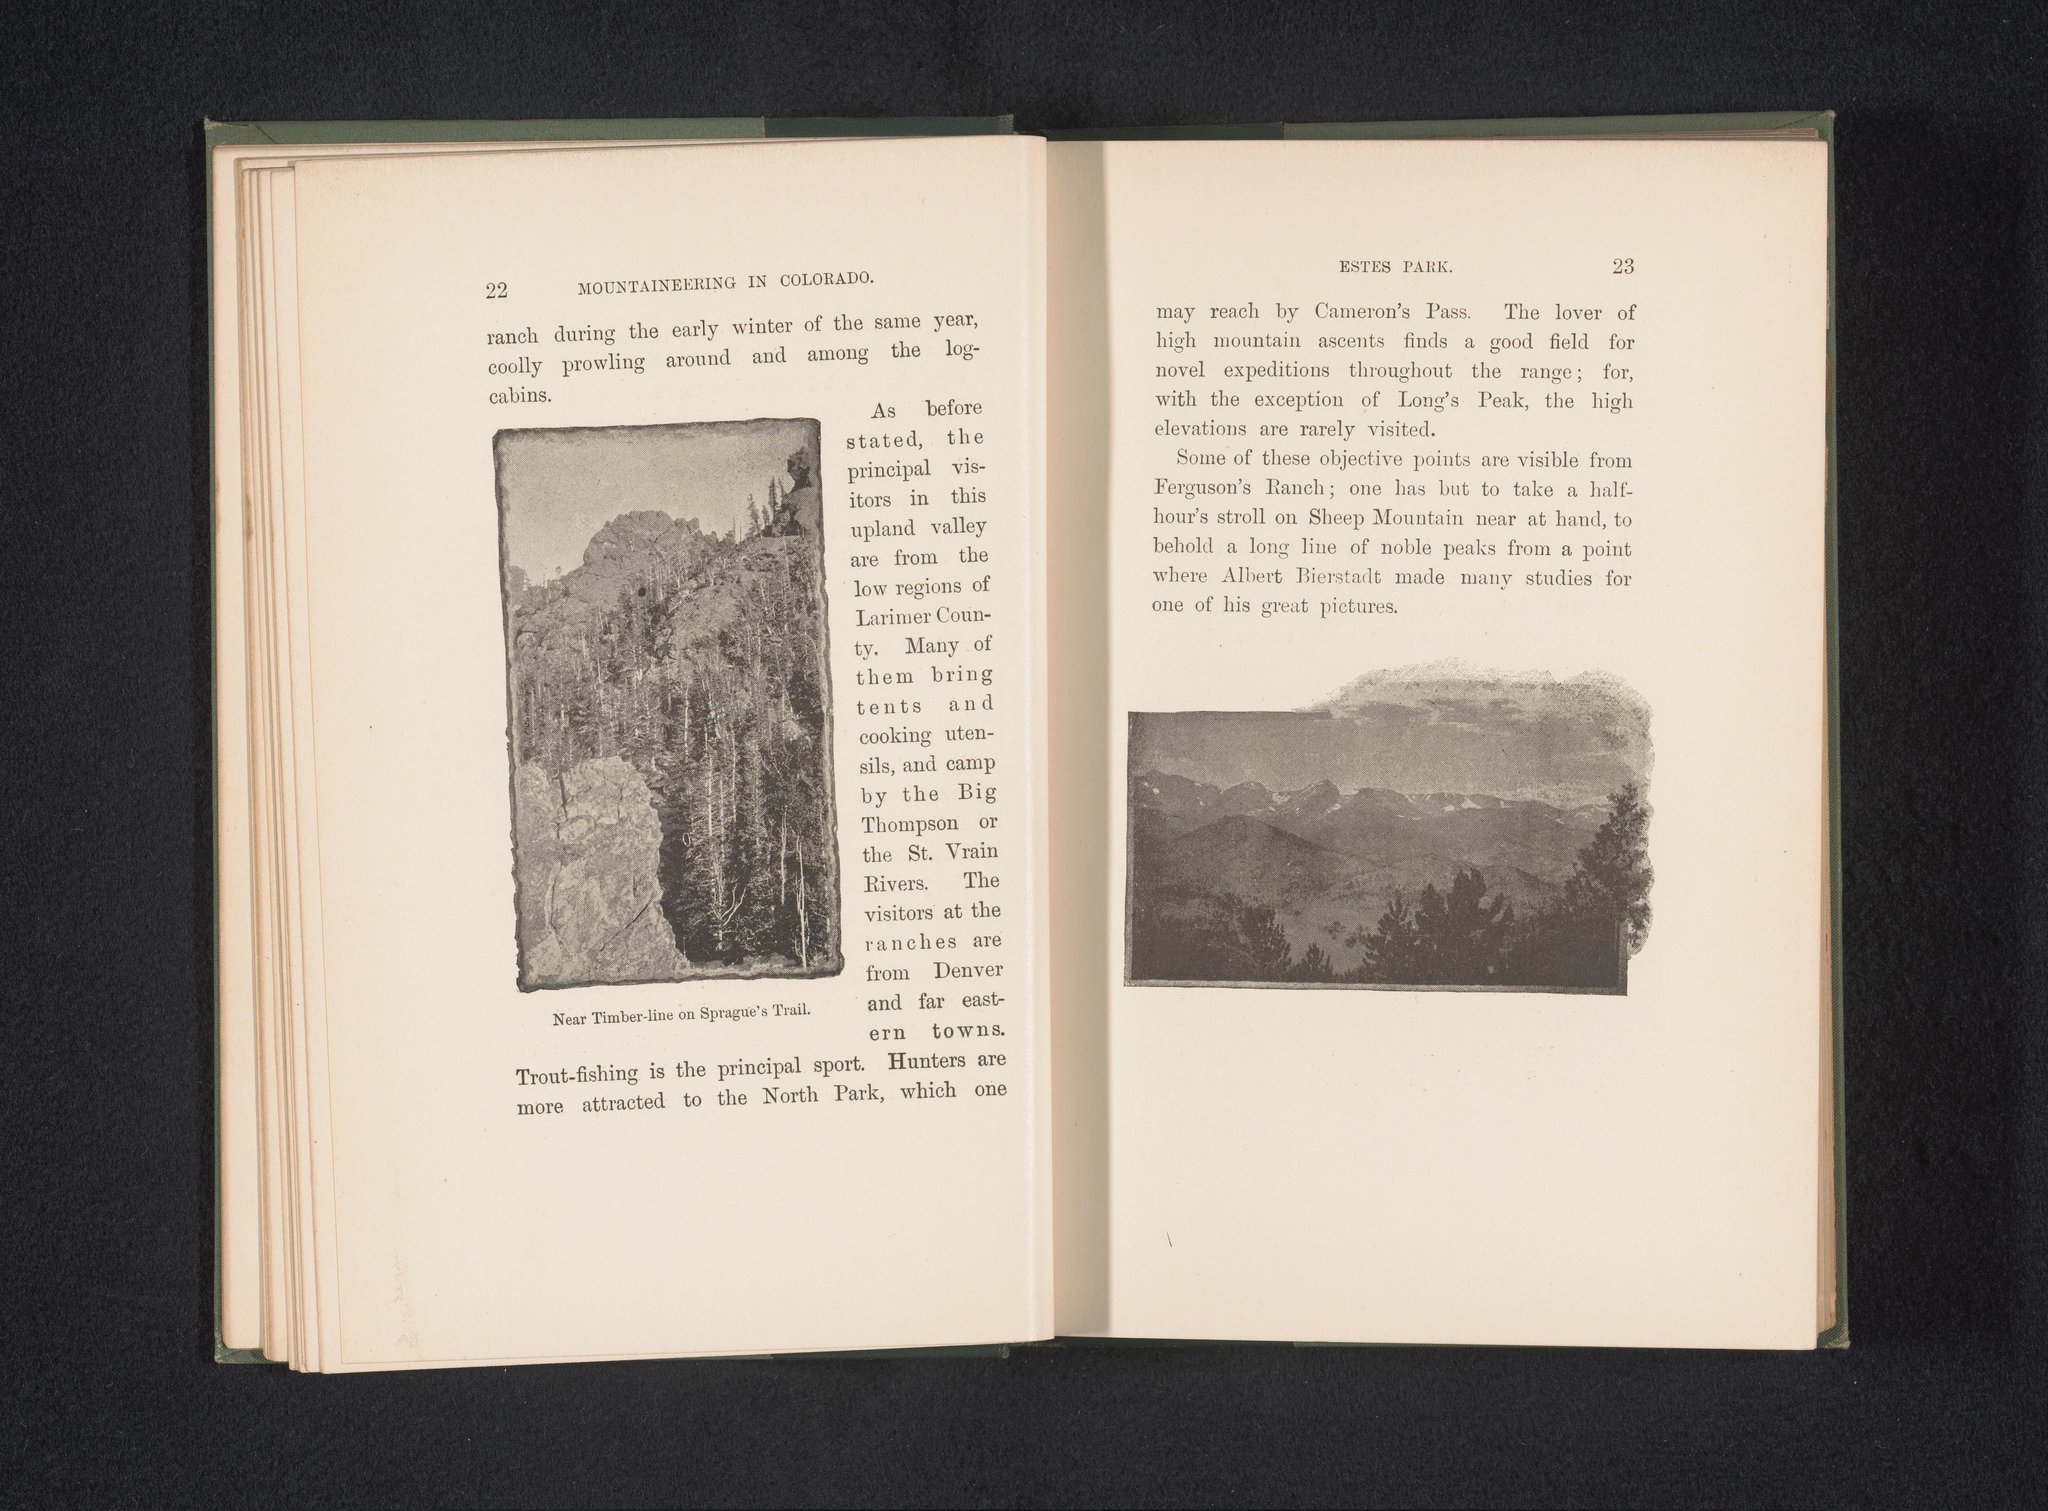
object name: page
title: Landschap met rotsen en bomen in het Rocky Mountain National Park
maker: frederick hastings chapin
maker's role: antropoloog, archeoloog, fotograaf, schrijver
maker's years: 1852-1900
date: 1885-1890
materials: paper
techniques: autotype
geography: boston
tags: landscapes, wildlife reserve, national park, mountains